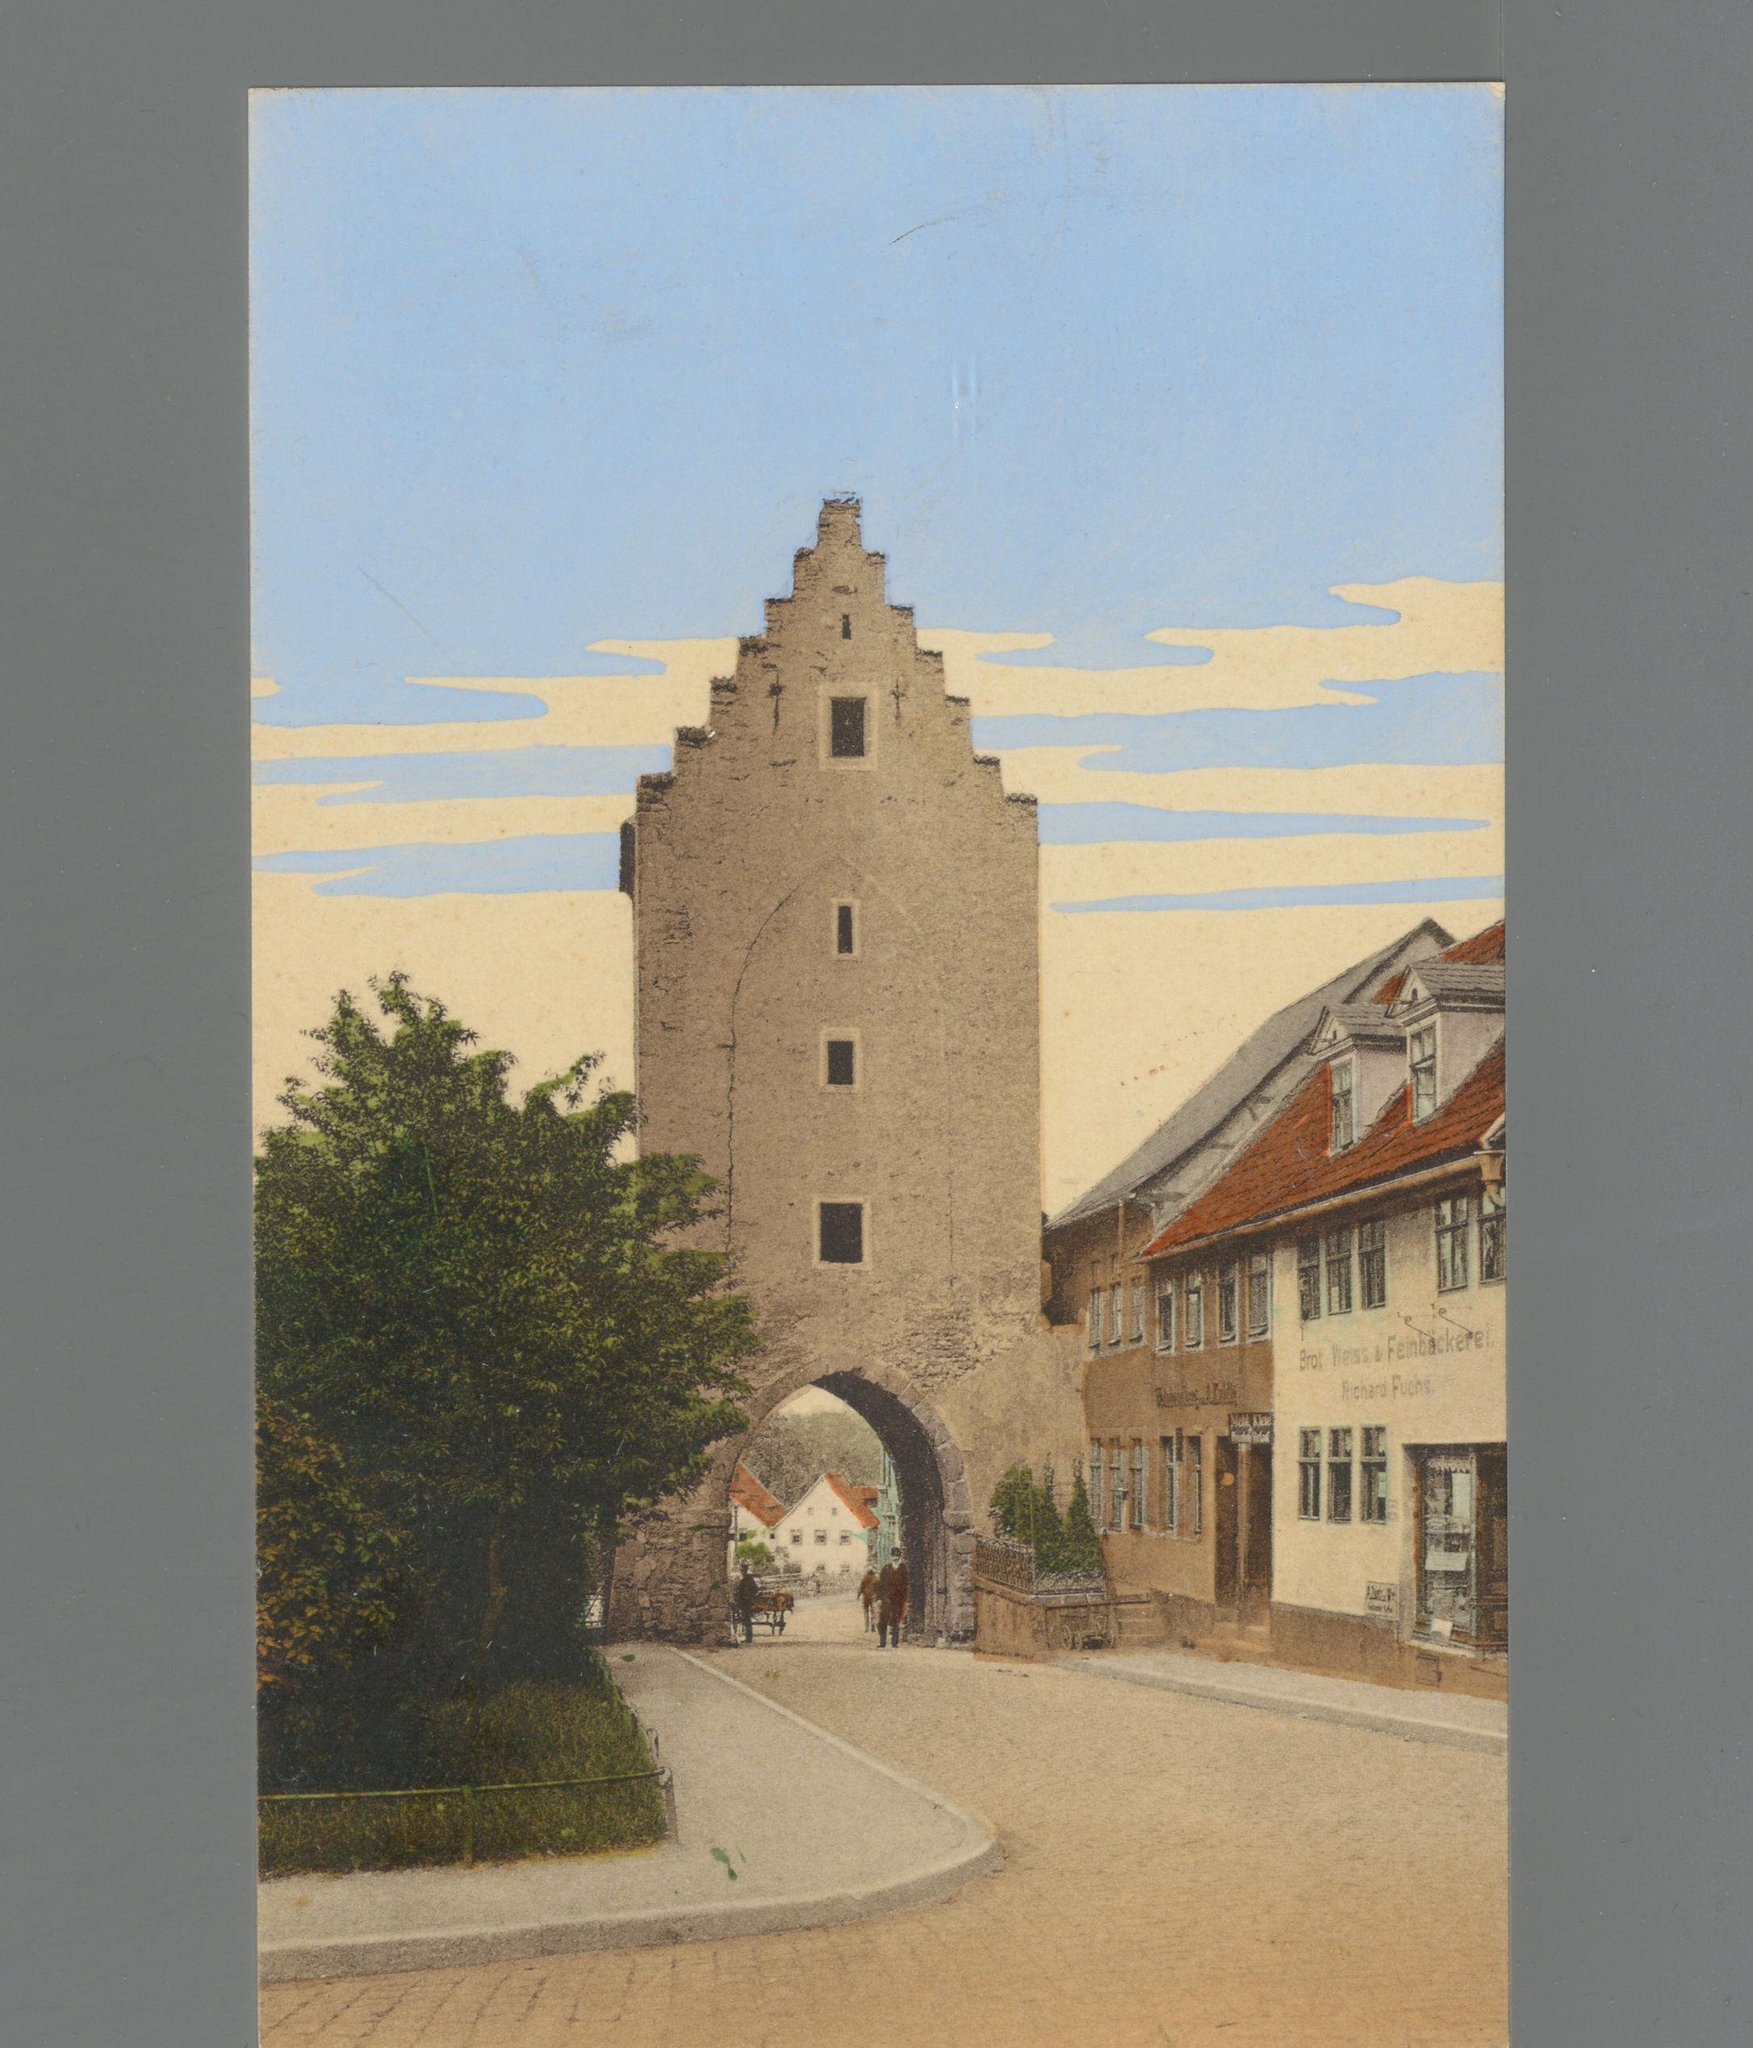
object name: ansichtkaart, prentbriefkaart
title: Saalfeld a. S. Saaltor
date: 1905-1930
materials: cardboard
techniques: photograph, lithograph, hand coloring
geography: saalfeld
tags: street, city-gate